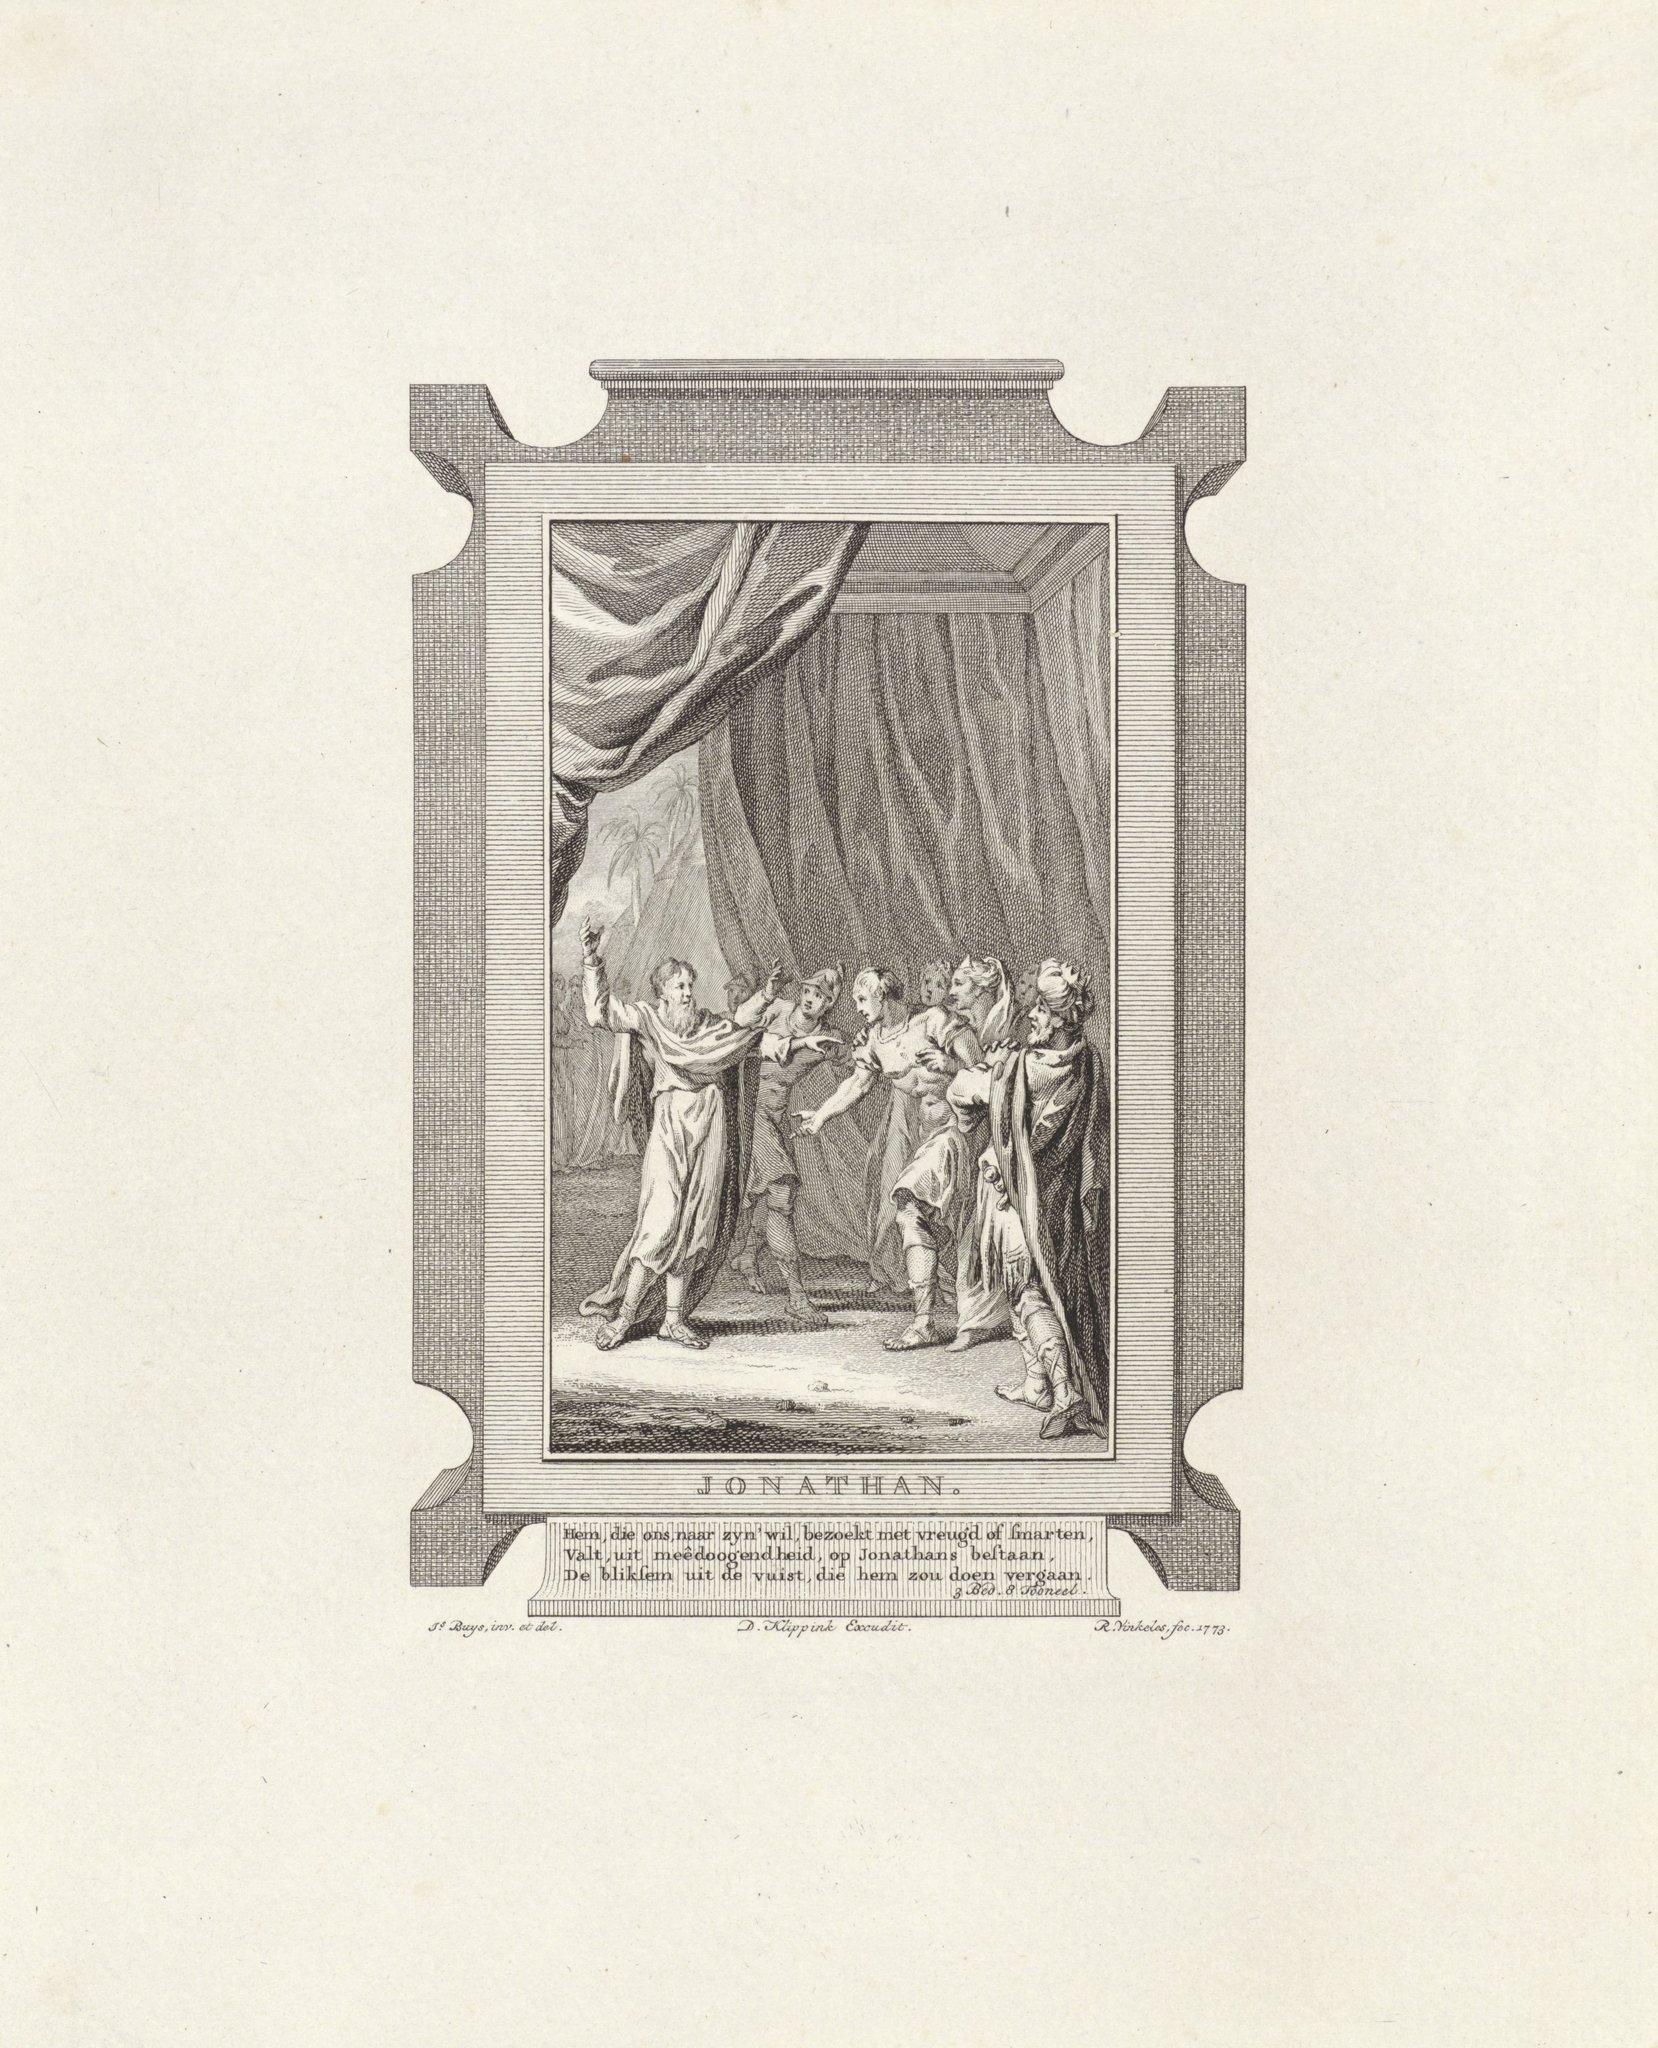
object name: print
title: Priester in gesprek met een koning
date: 1773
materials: paper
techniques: engraving, etching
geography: amsterdam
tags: ruler, sovereign, conversation, dialogue; conversation piece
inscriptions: collector's mark: Lugt 240